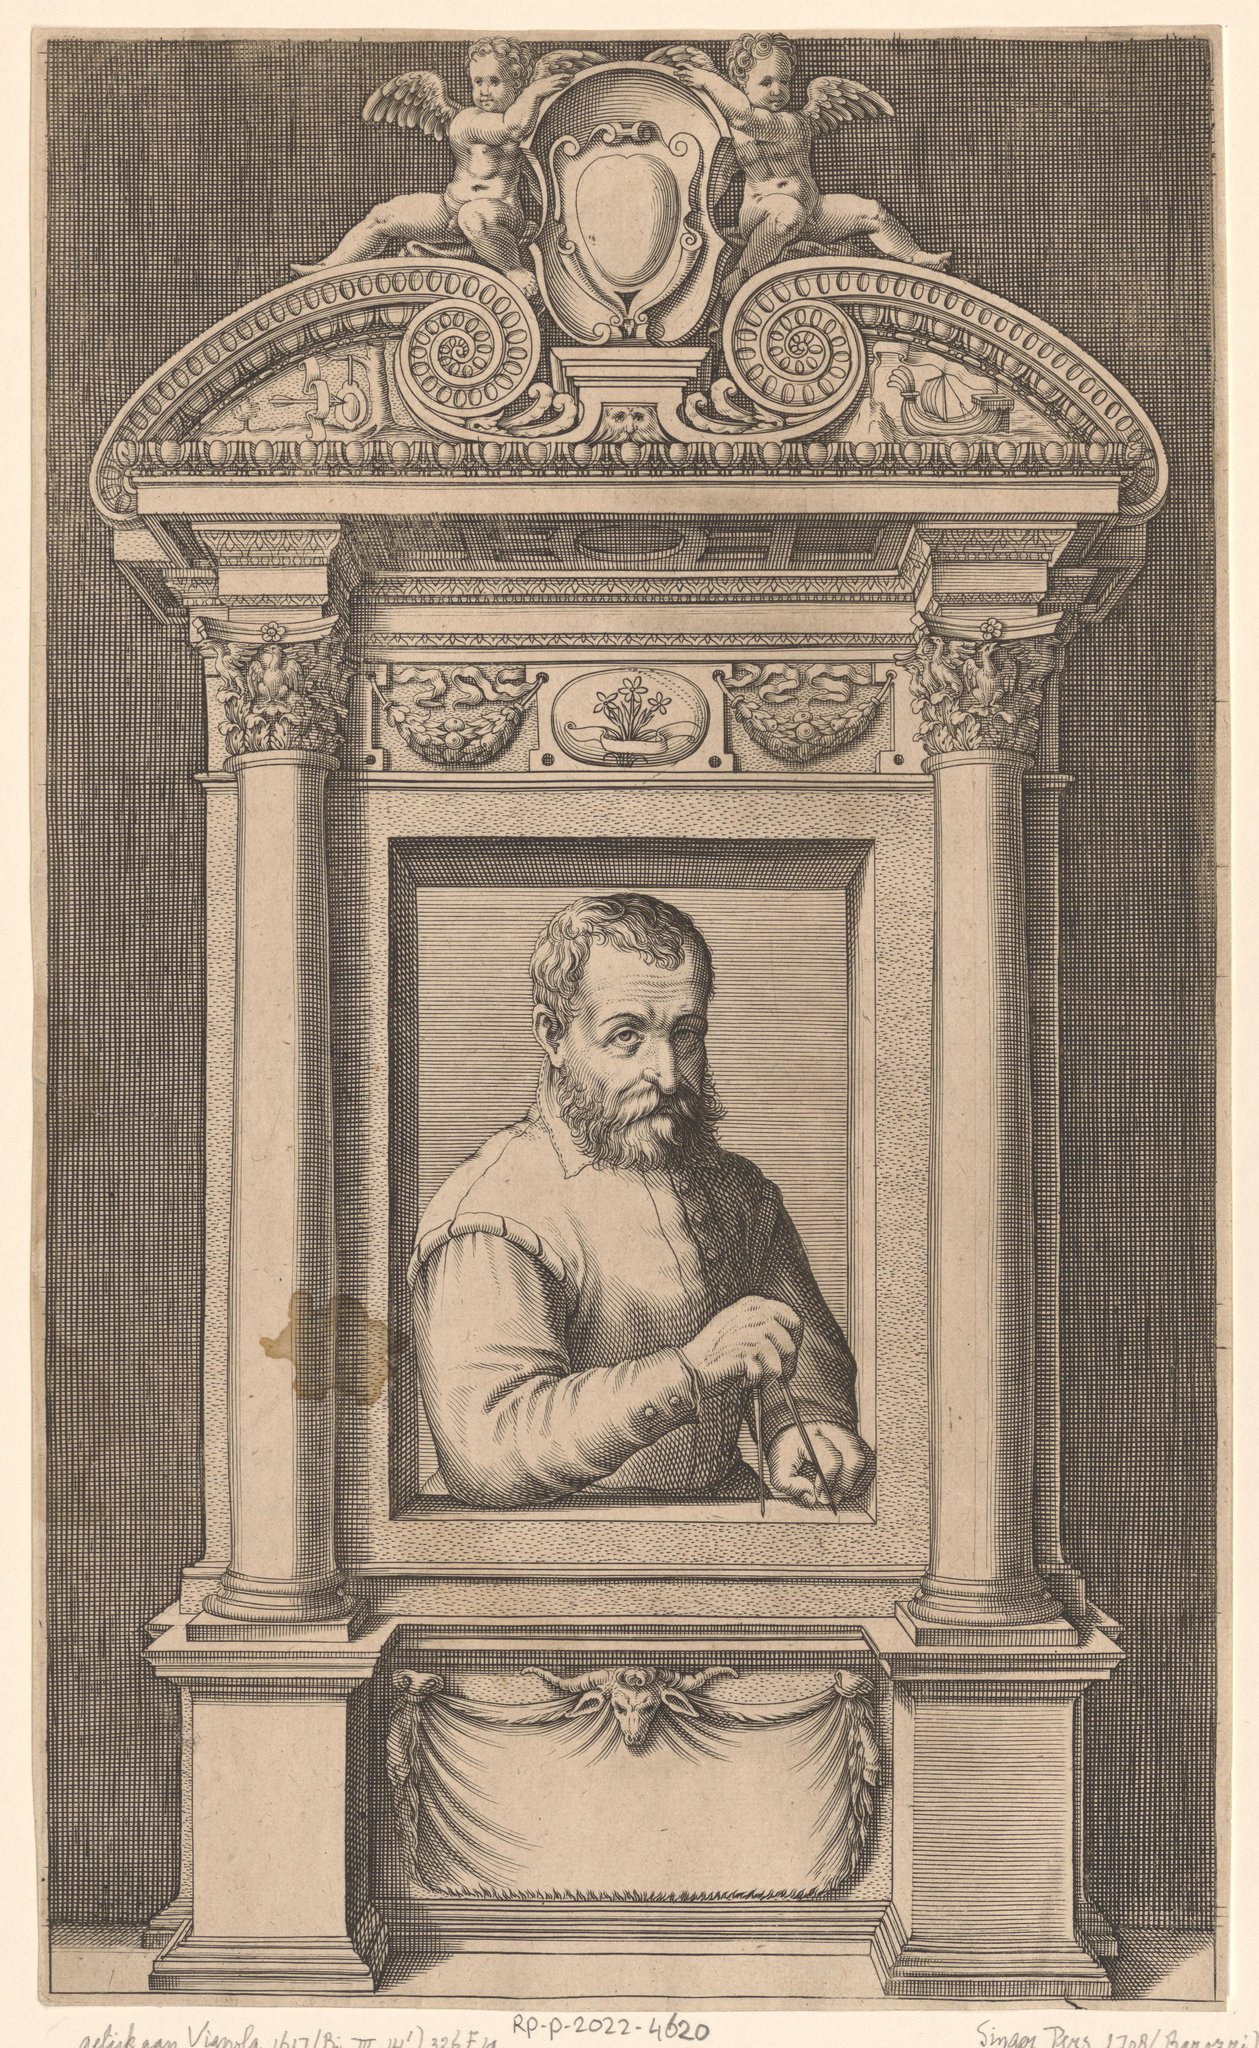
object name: print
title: Portret van Giacomo Barozzi da Vignola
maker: Anonymous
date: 1617-1640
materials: paper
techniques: engraving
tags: historical persons, portrait, self-portrait of architect, ornament derived from architectural details, cupids: 'amores', 'amoretti', 'putti', tools, implements of architect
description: Prent waarschijnlijk uit: Vignola, Giacomo Barozzi da. Regel van de vijf ordens der architecture (...). Amsterdam: Willem Jansz., 1617. Prent mogelijk ook gebruikt in de editie uit 1640.